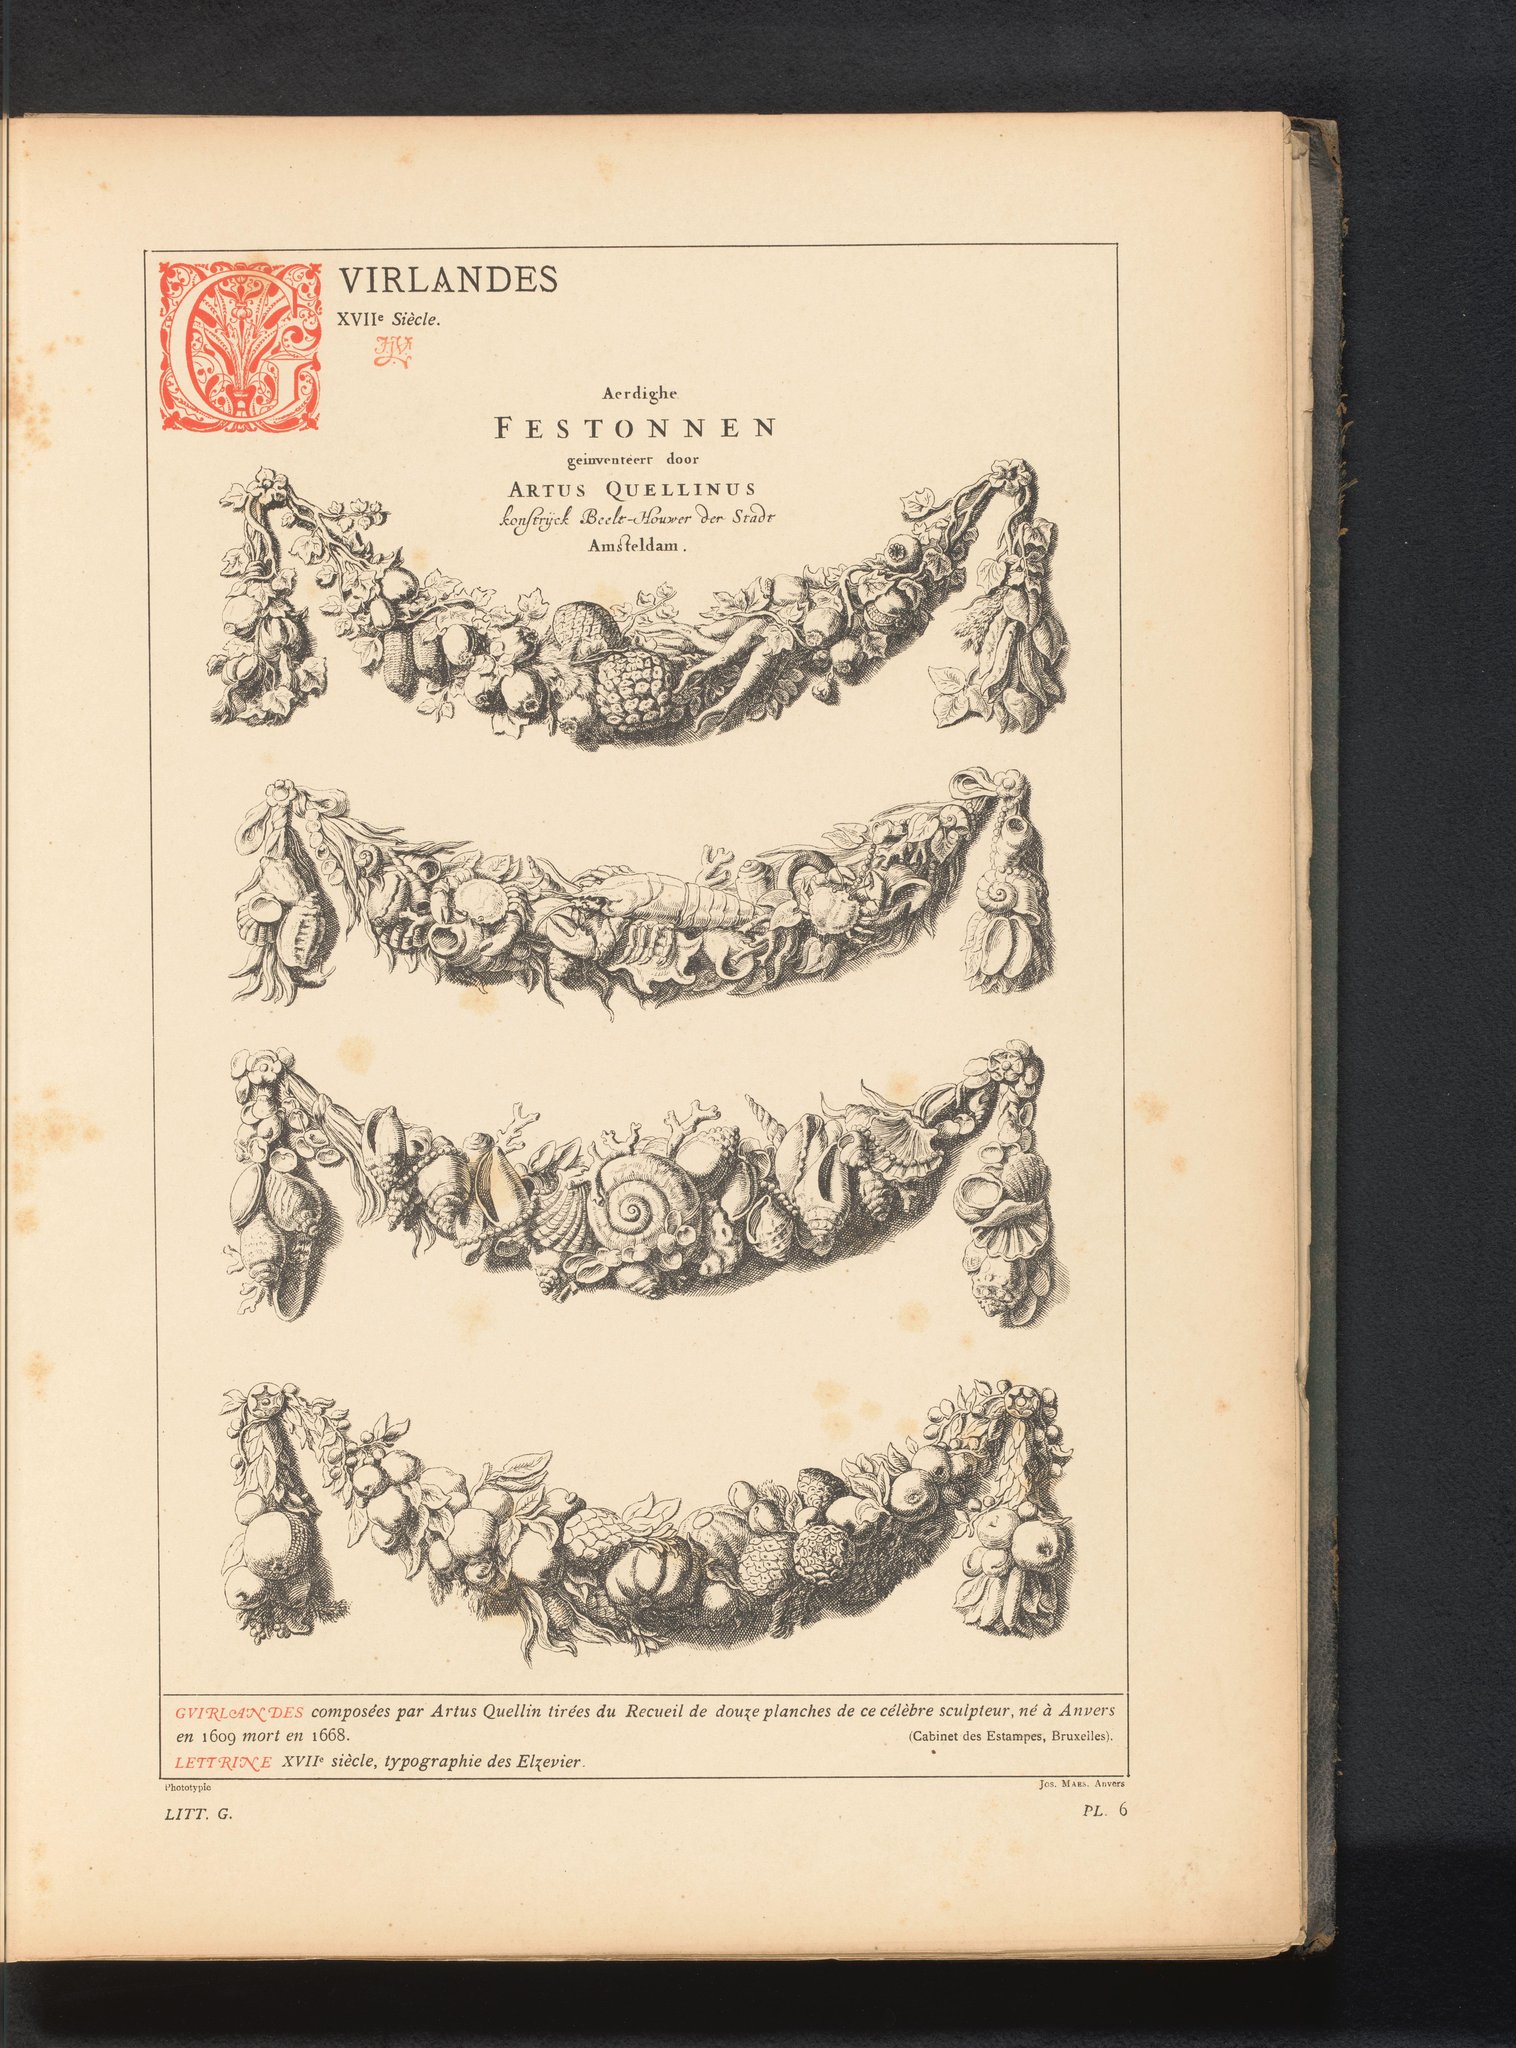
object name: photomechanical print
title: Guirlandes, XVIIe Siècle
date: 1875-1880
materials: paper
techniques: photolithography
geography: antwerp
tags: garland, wreath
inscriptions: inscription: ‘GUIRLANDES composées par (...)’, inscription: ‘LITT. G. - PL. 6.’, monogram: ‘JJvY’